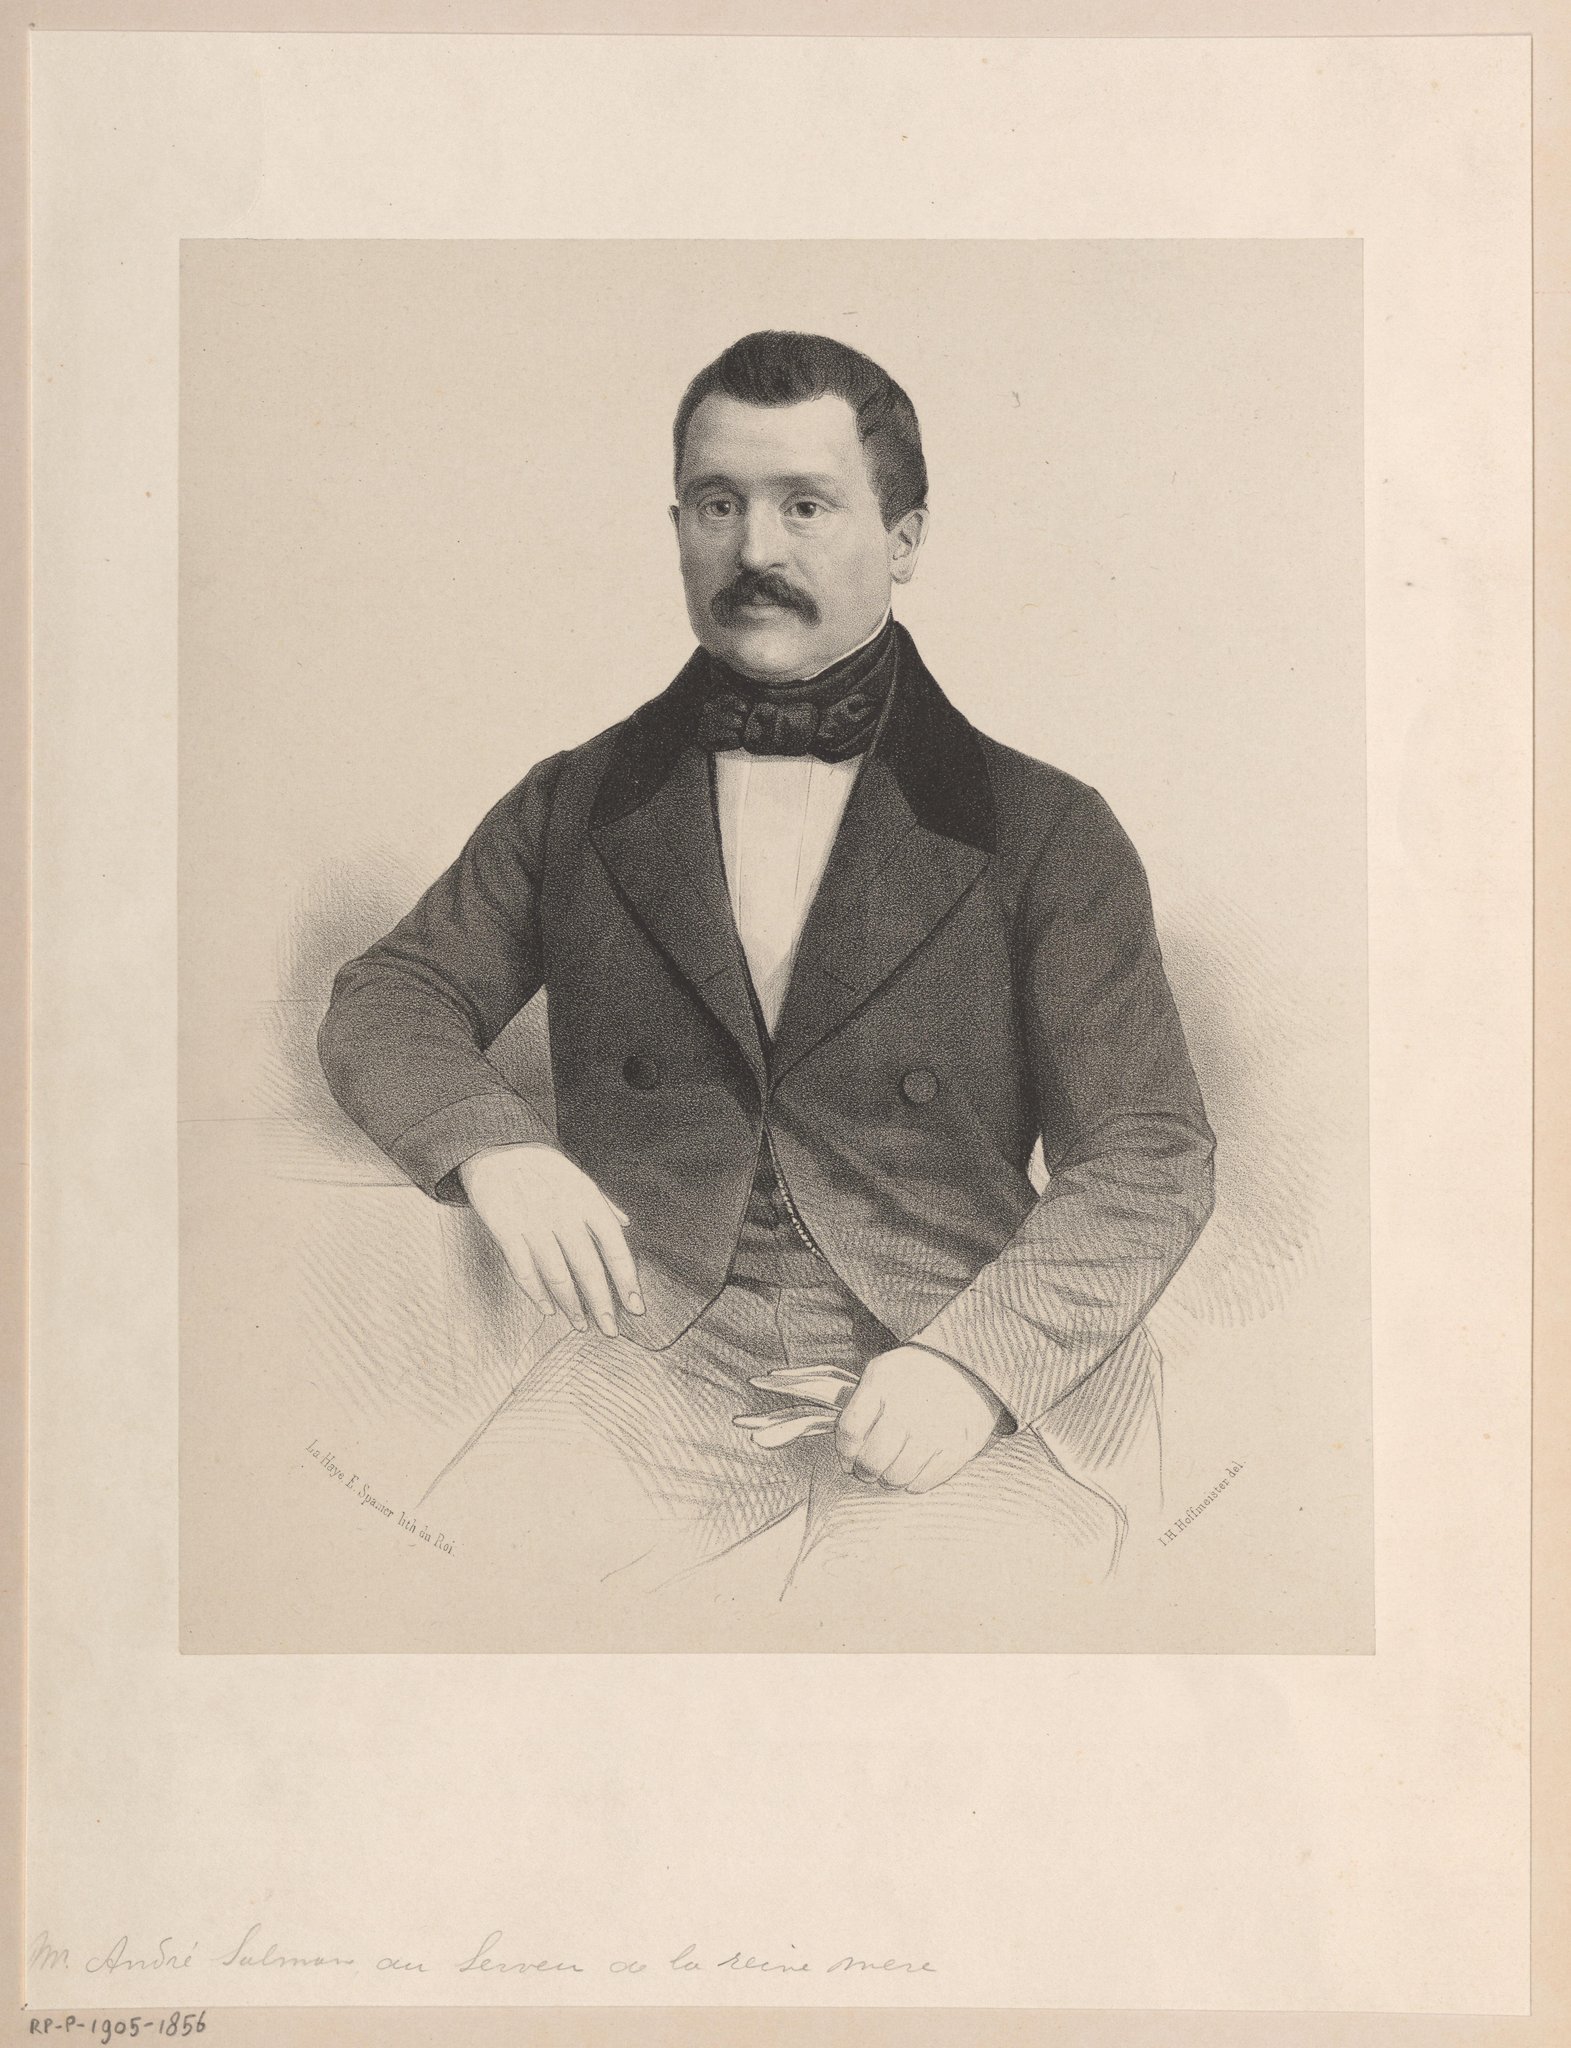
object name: print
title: Portret van André Salmon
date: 1843-1863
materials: paper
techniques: lithograph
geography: the hague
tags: gloves, mittens, etc., historical persons